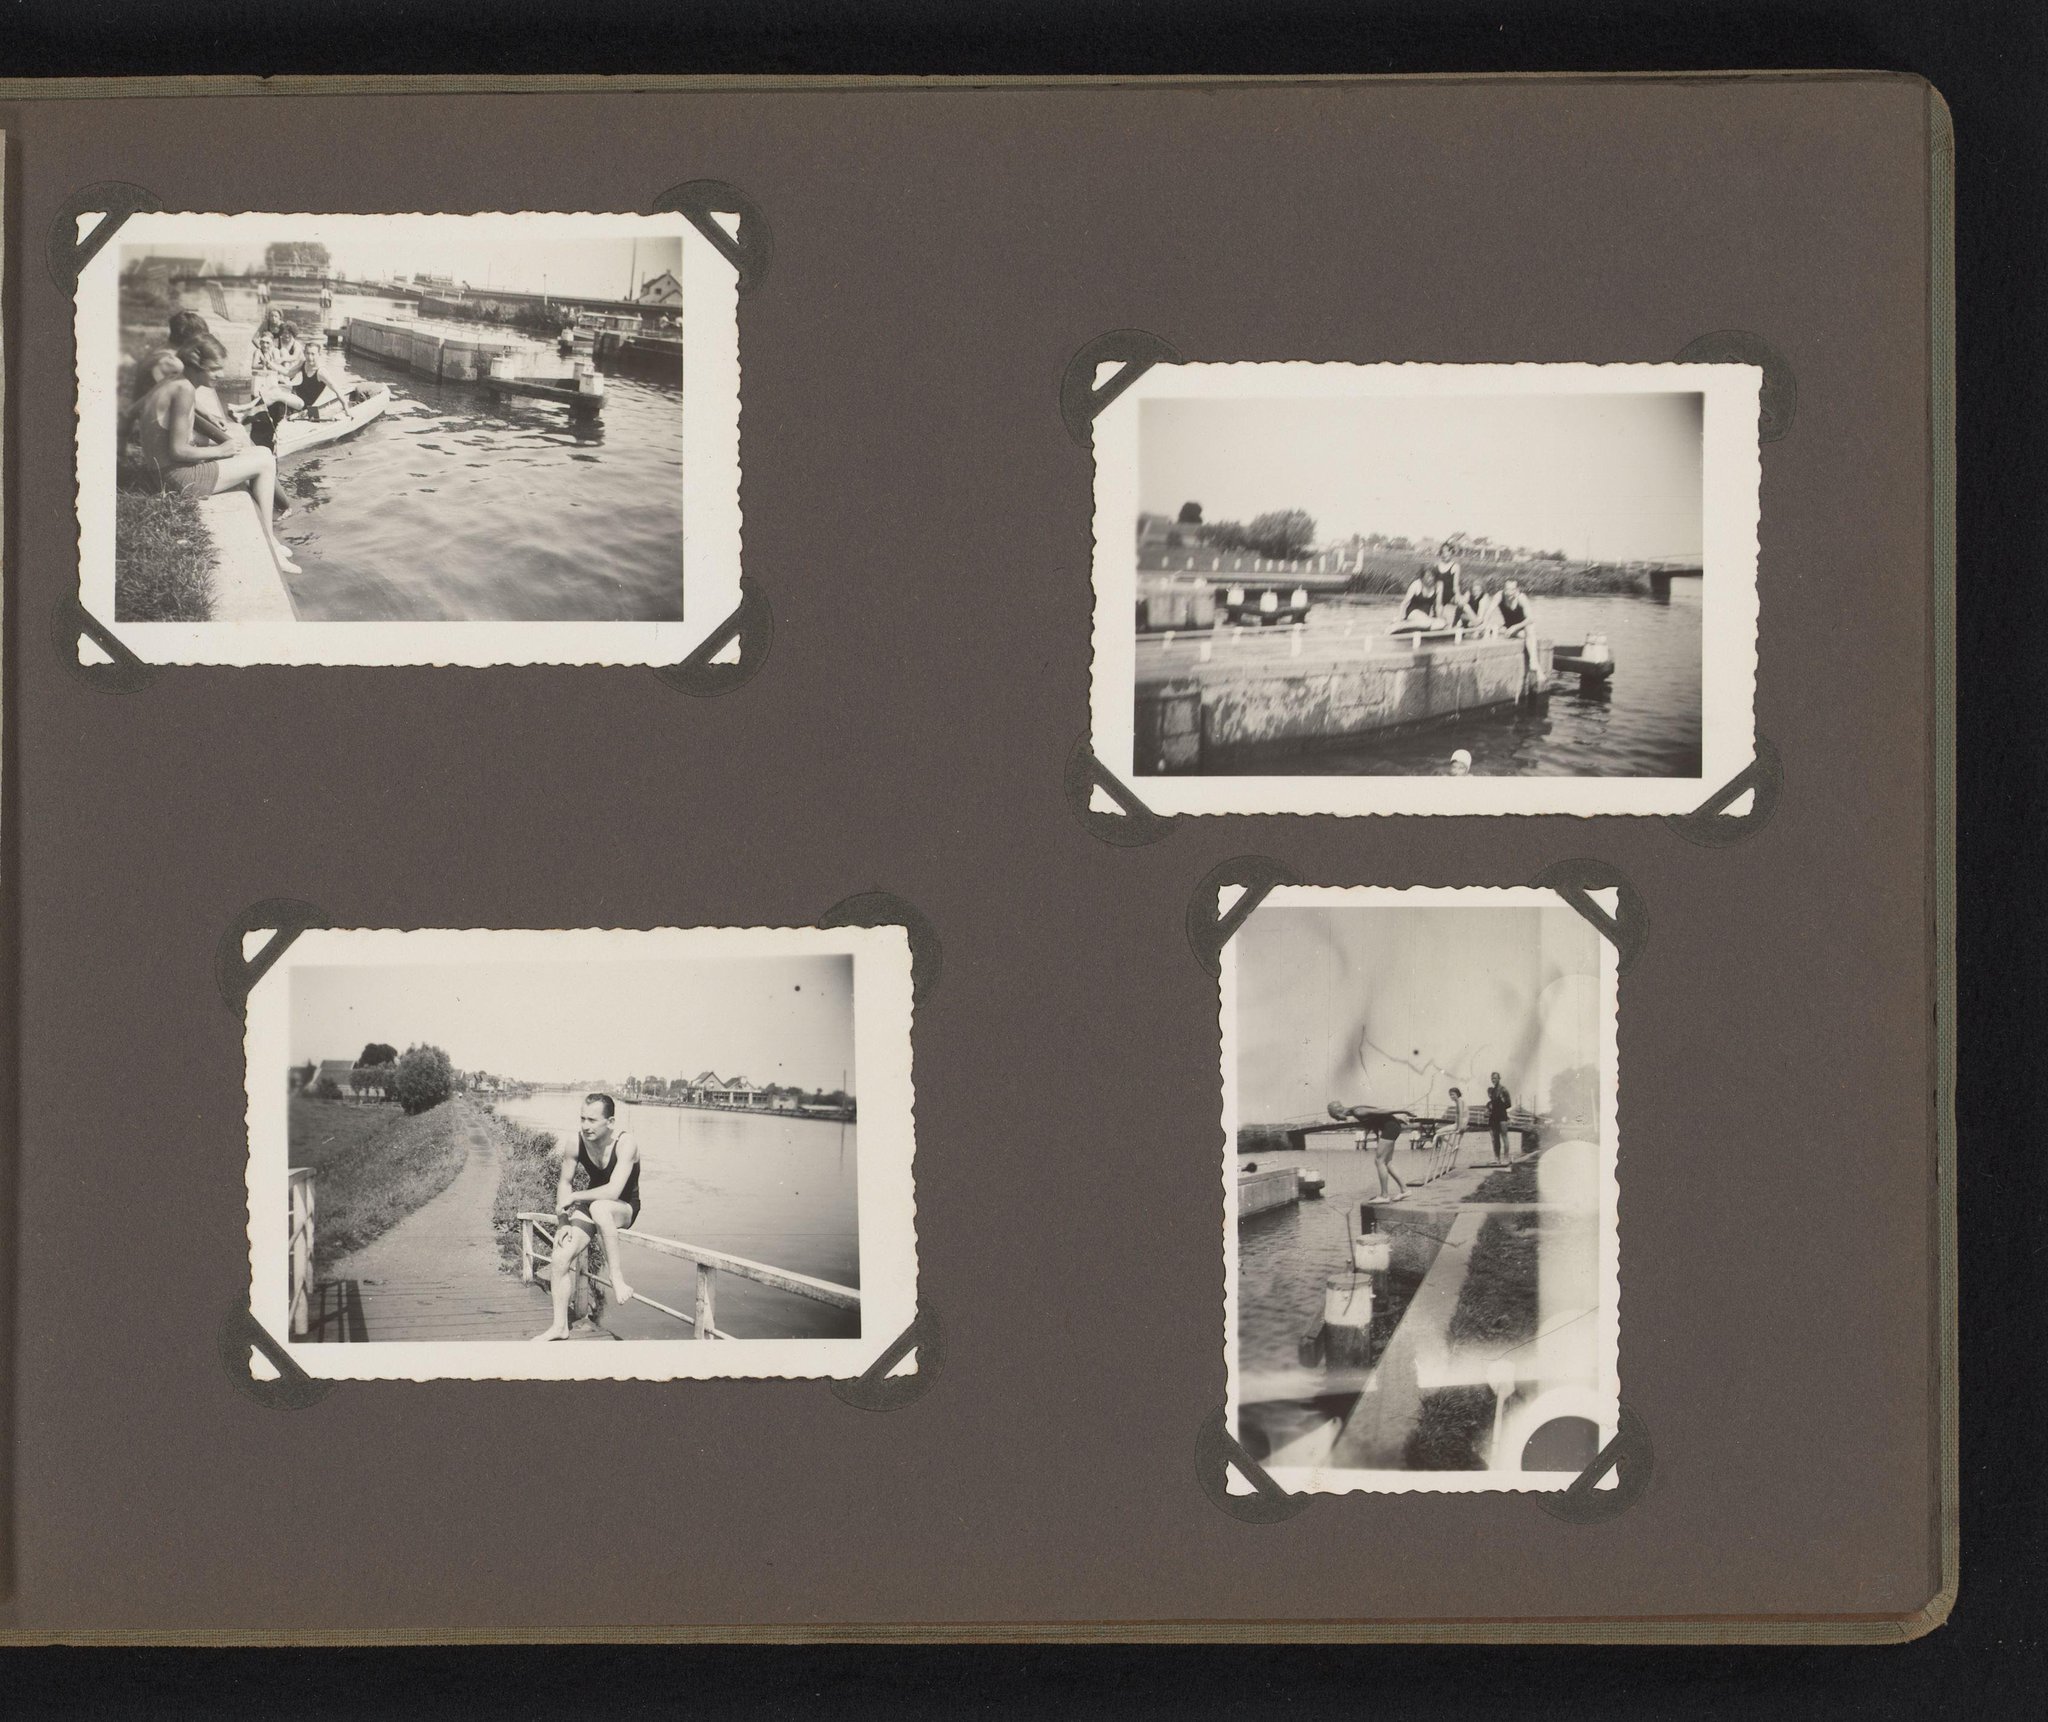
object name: album leaf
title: Zwemmen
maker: Anonymous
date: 1935-1945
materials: cardboard, photographic support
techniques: gelatin silver print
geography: netherlands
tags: student vacation, swimming (sport), open-air recreation, netherlands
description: Albumblad met vier foto's van zwemmen met een groep vrienden. Onderdeel van het fotoalbum van een jonge vrouw, ca. 1935-1945.